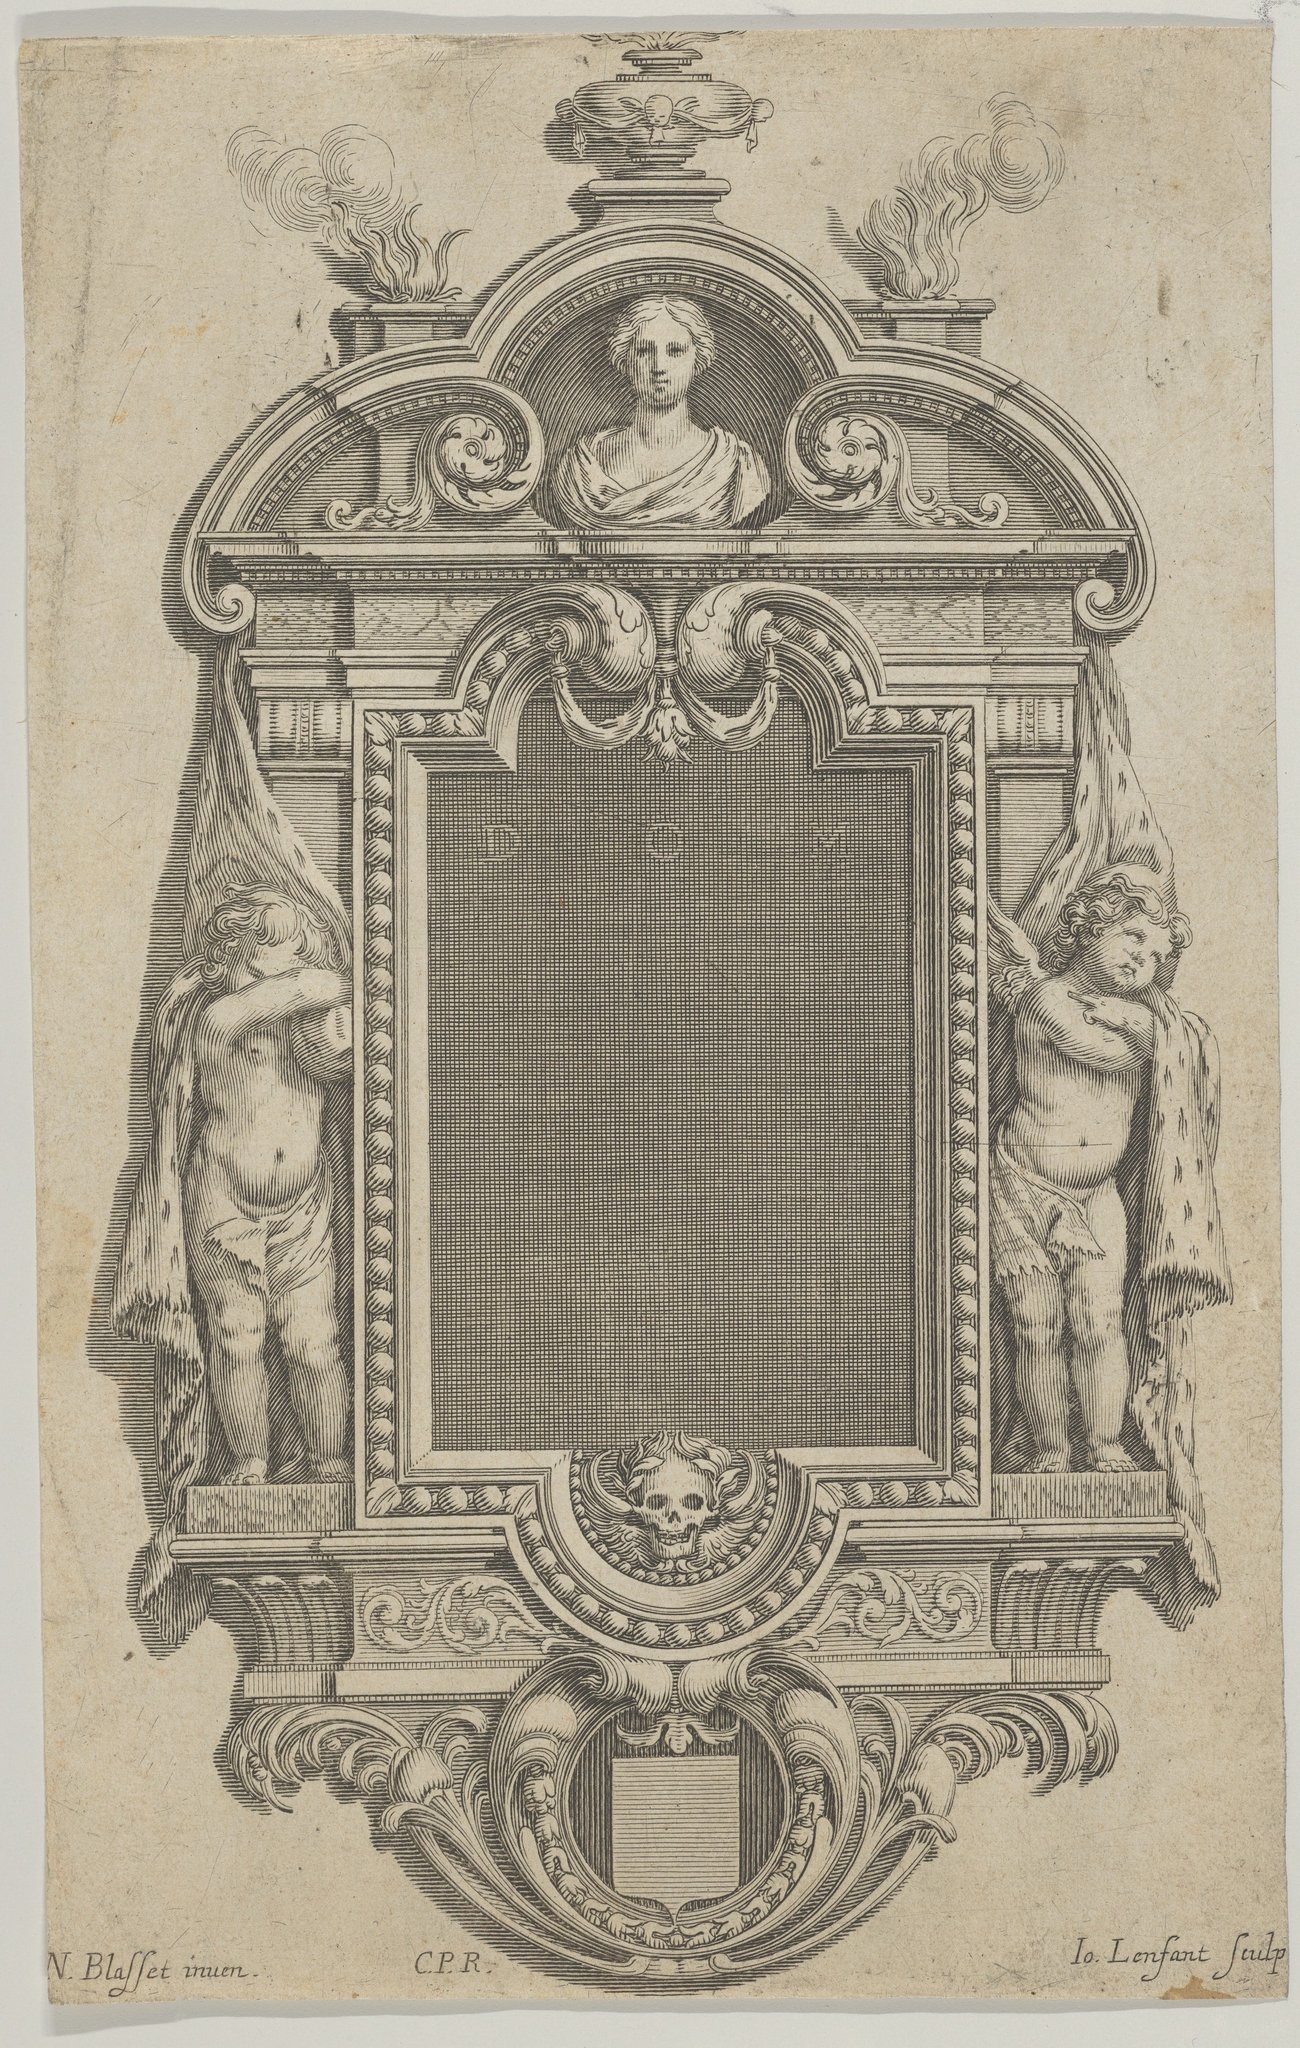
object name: print ornament architecture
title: Design for an Epitaph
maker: jean lenfant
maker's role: artist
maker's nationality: french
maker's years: 1615-1674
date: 1660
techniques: etching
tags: shields,women,angels